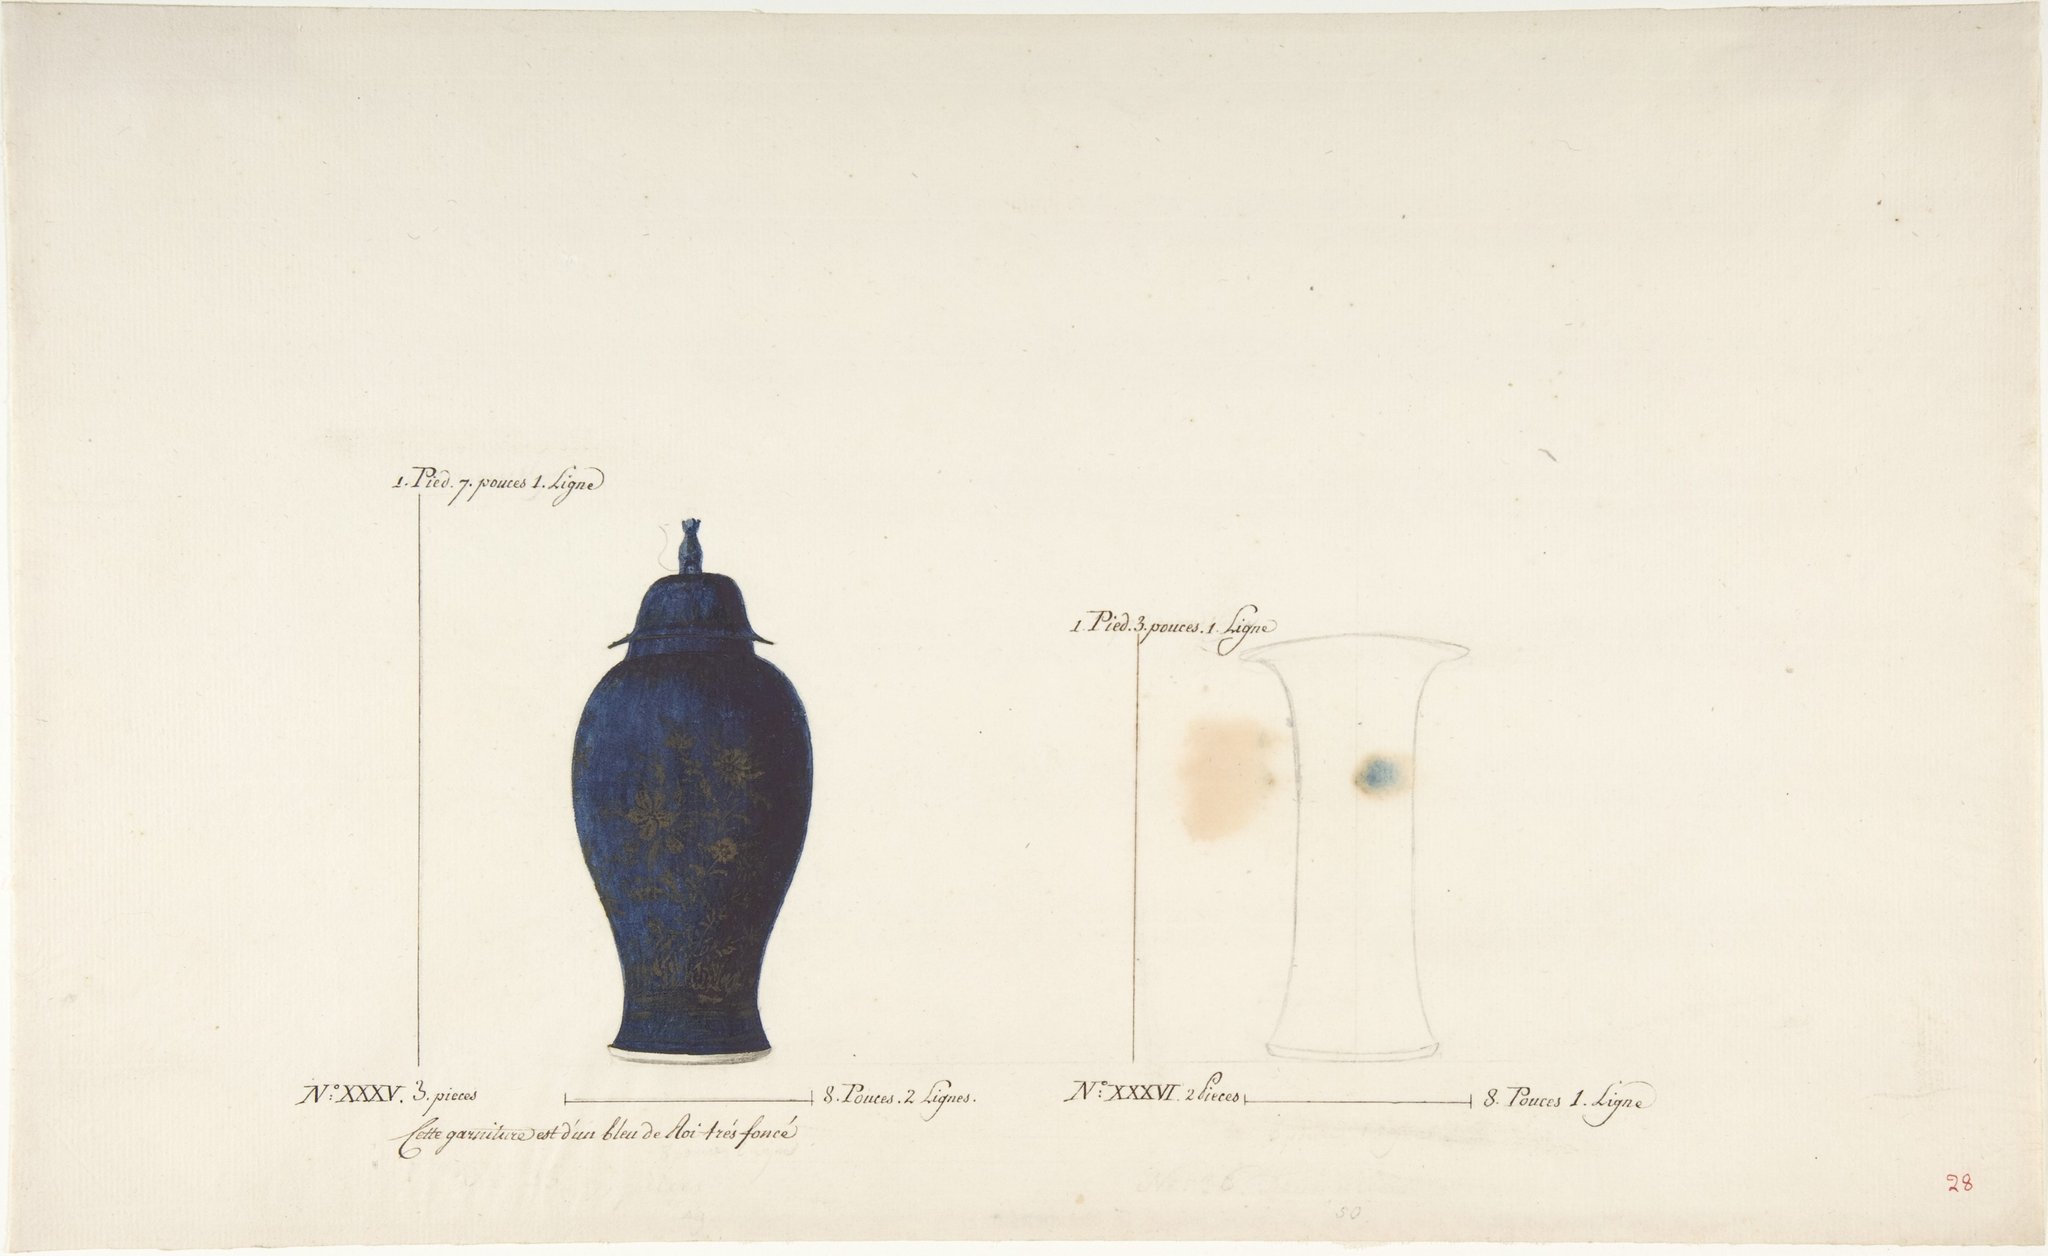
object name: drawing ornament architecture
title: Design for Two Vases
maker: anonymous, french, 18th century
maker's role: artist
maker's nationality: french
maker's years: 1700-1800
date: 1770-1785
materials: chalk, ink, watercolor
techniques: pen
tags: vases